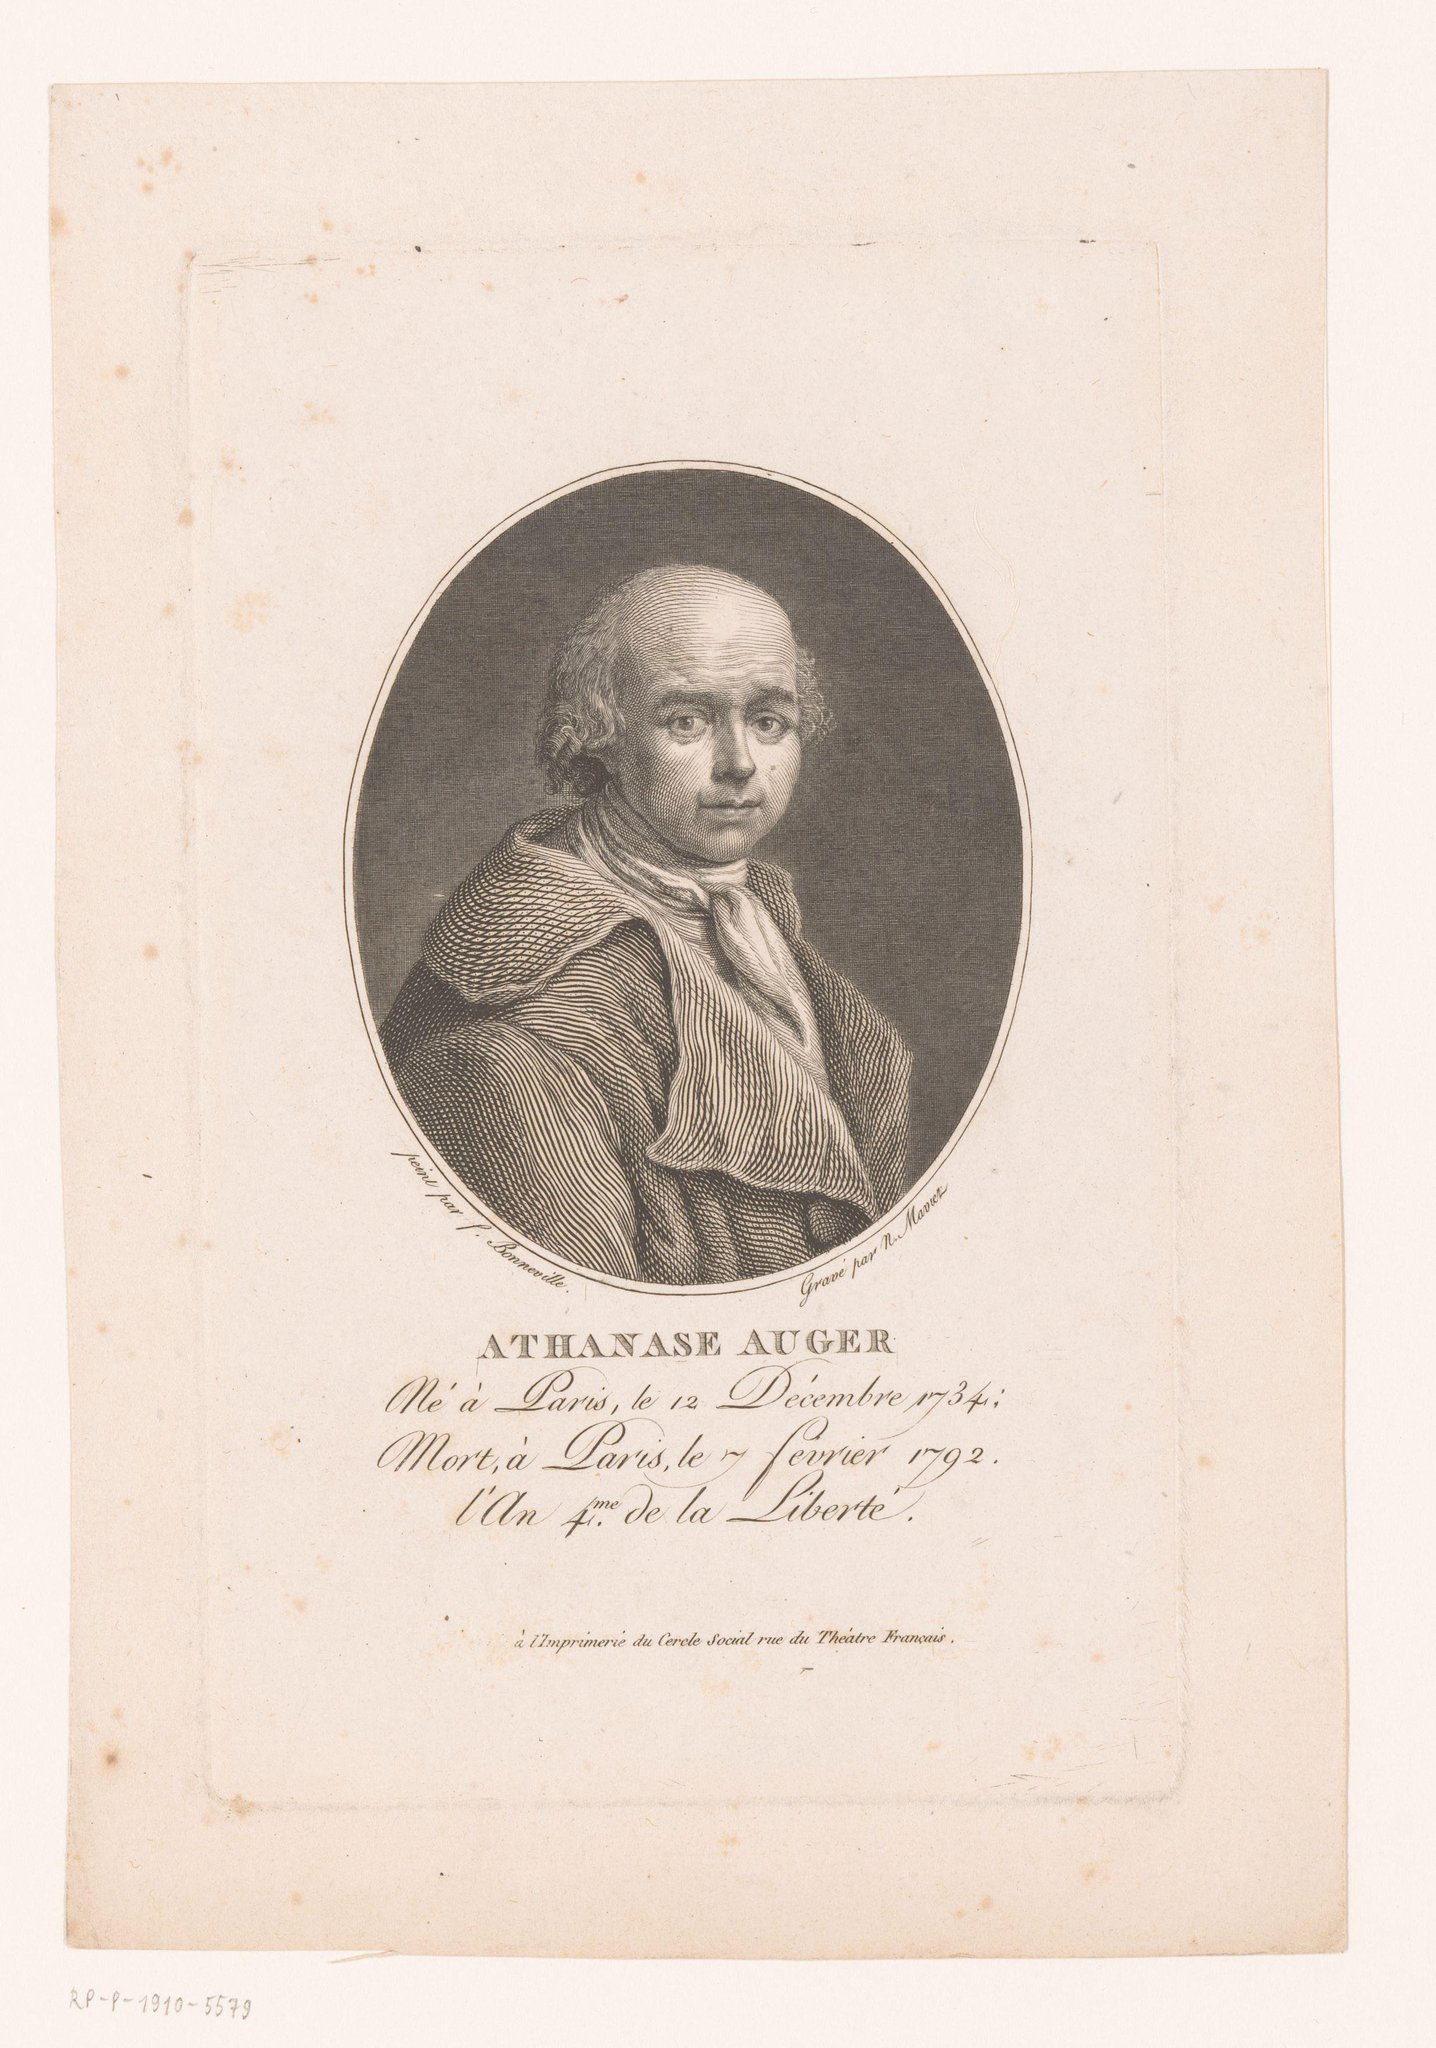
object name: print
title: Portret van Athanase Auger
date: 1795-1805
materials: paper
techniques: engraving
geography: france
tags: paris, historical persons, professor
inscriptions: collector's mark: Lugt 2228